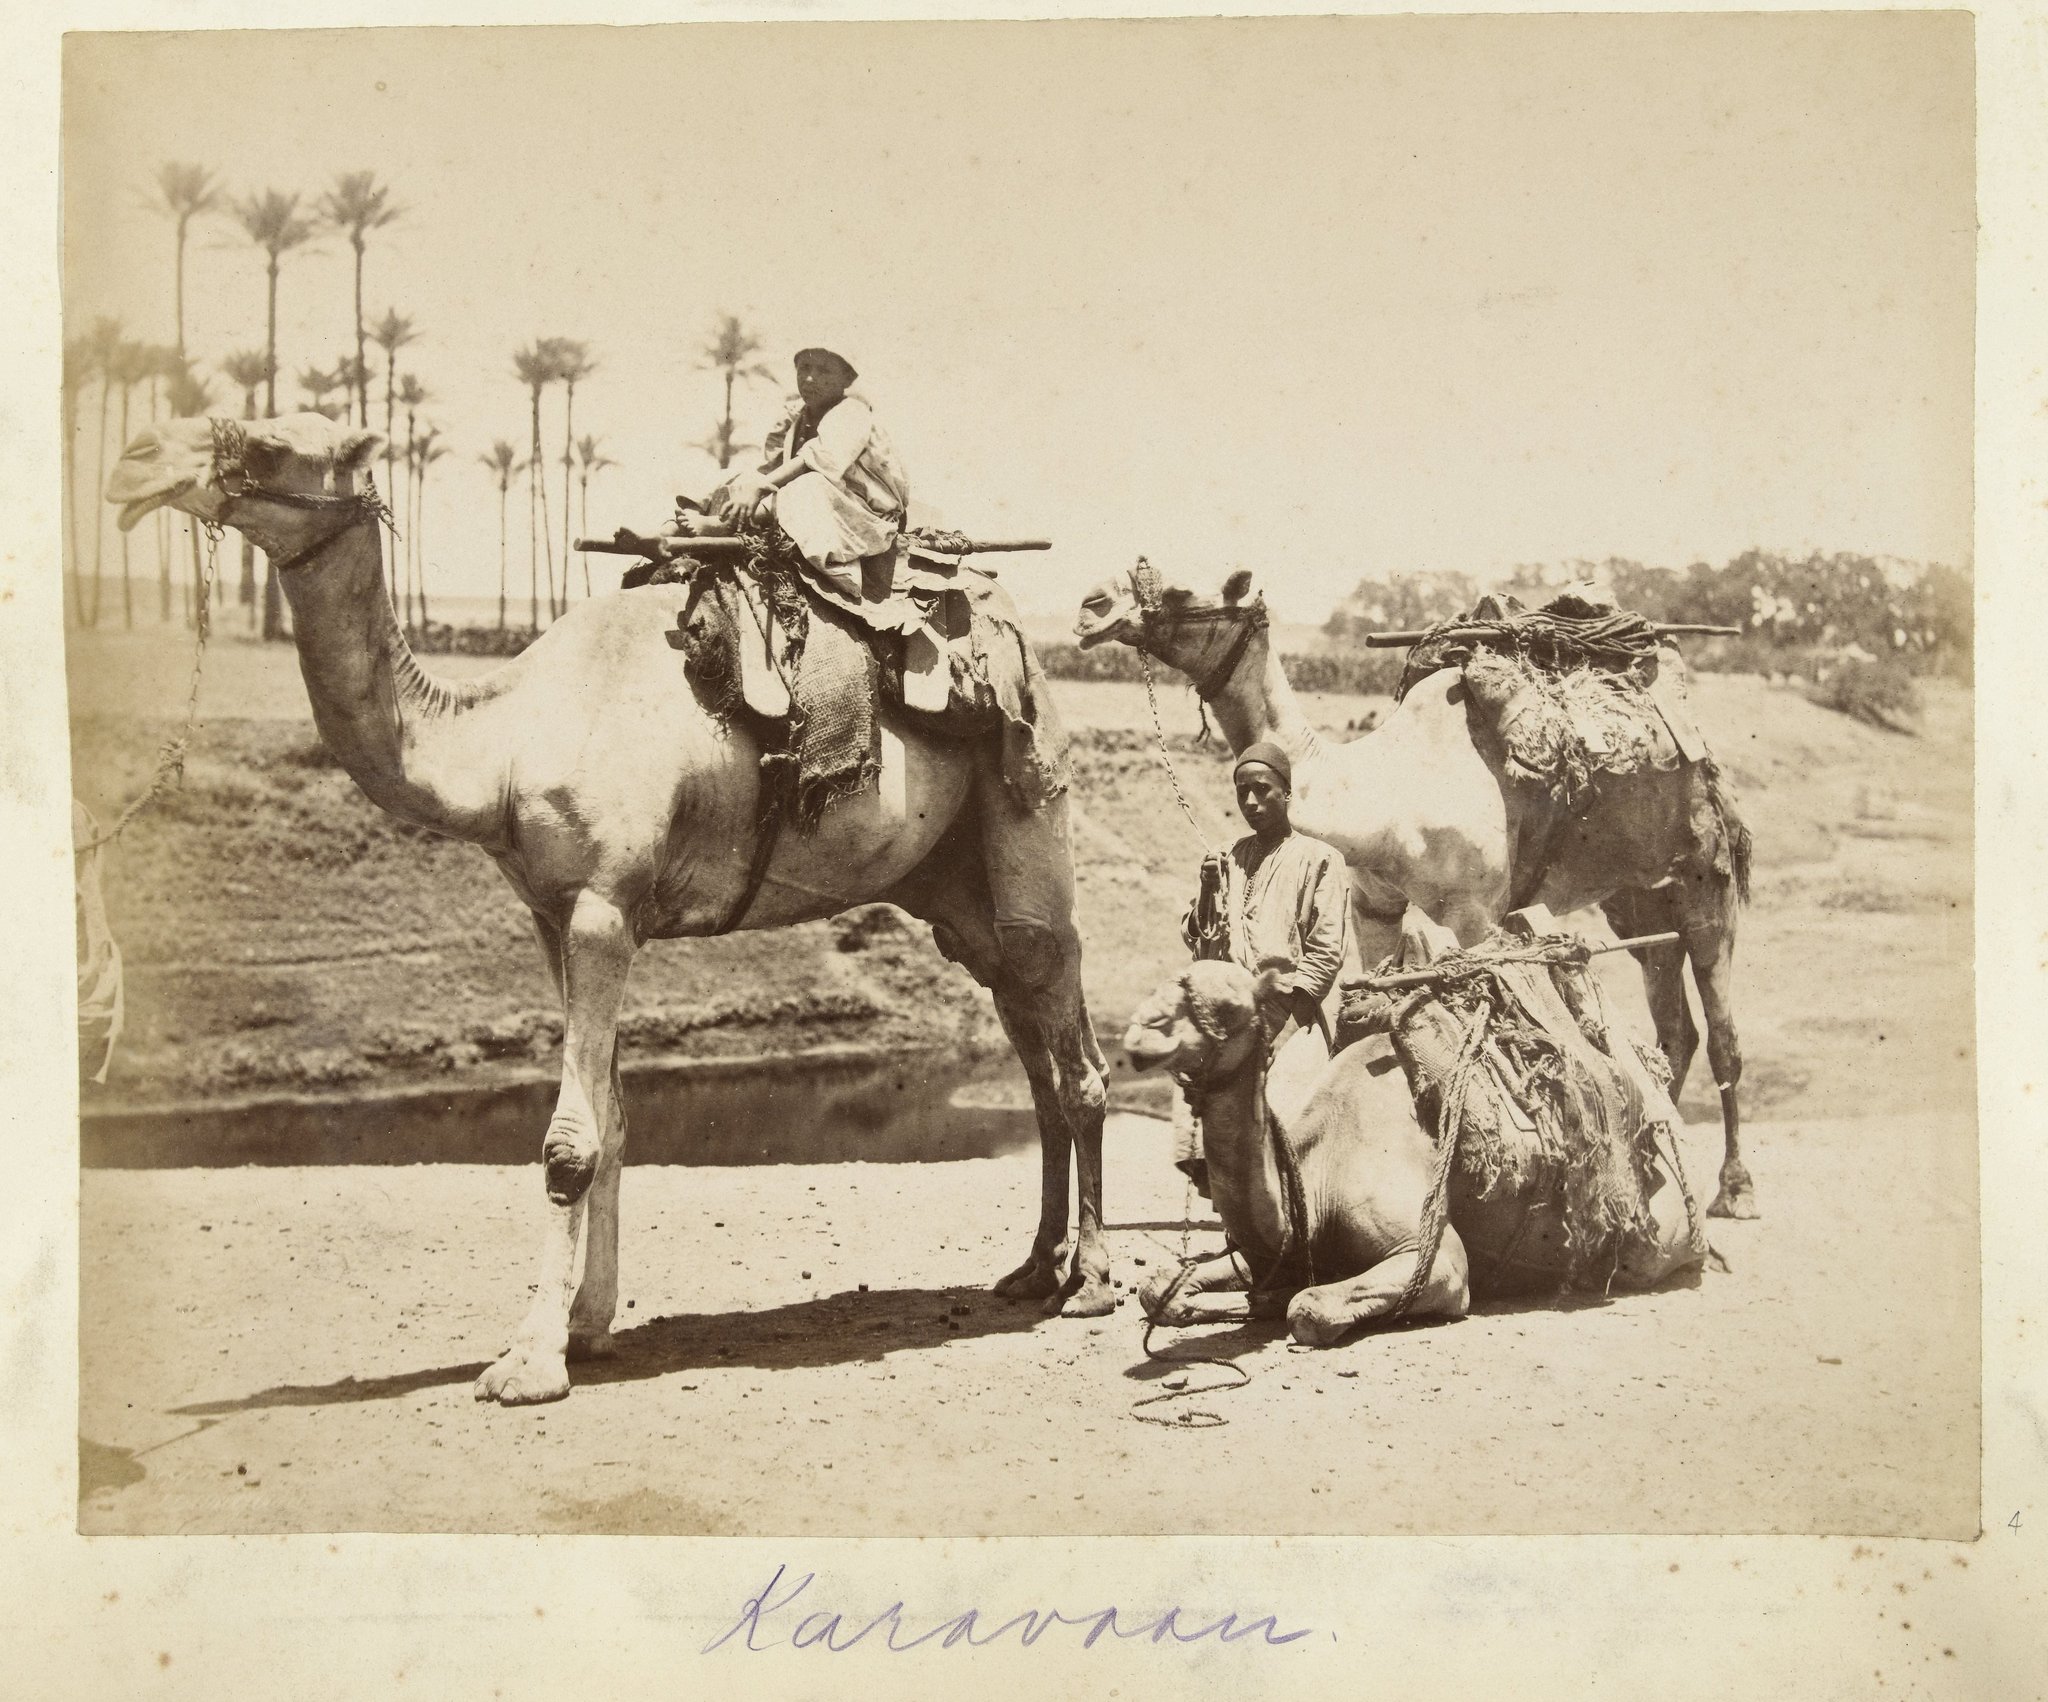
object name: photograph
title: Karavaan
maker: Anonymous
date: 1890-1910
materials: cardboard, paper, photographic support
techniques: gelatin silver print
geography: egypt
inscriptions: caption: ‘Karavaan’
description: Twee jongens bij bepakte drommedarissen als onderdeel van een karavaan.